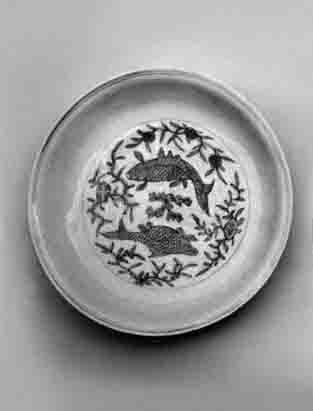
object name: dish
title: Dish with fish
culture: chinese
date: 1567-1600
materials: cobalt, porcelain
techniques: painting, underglaze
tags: fish